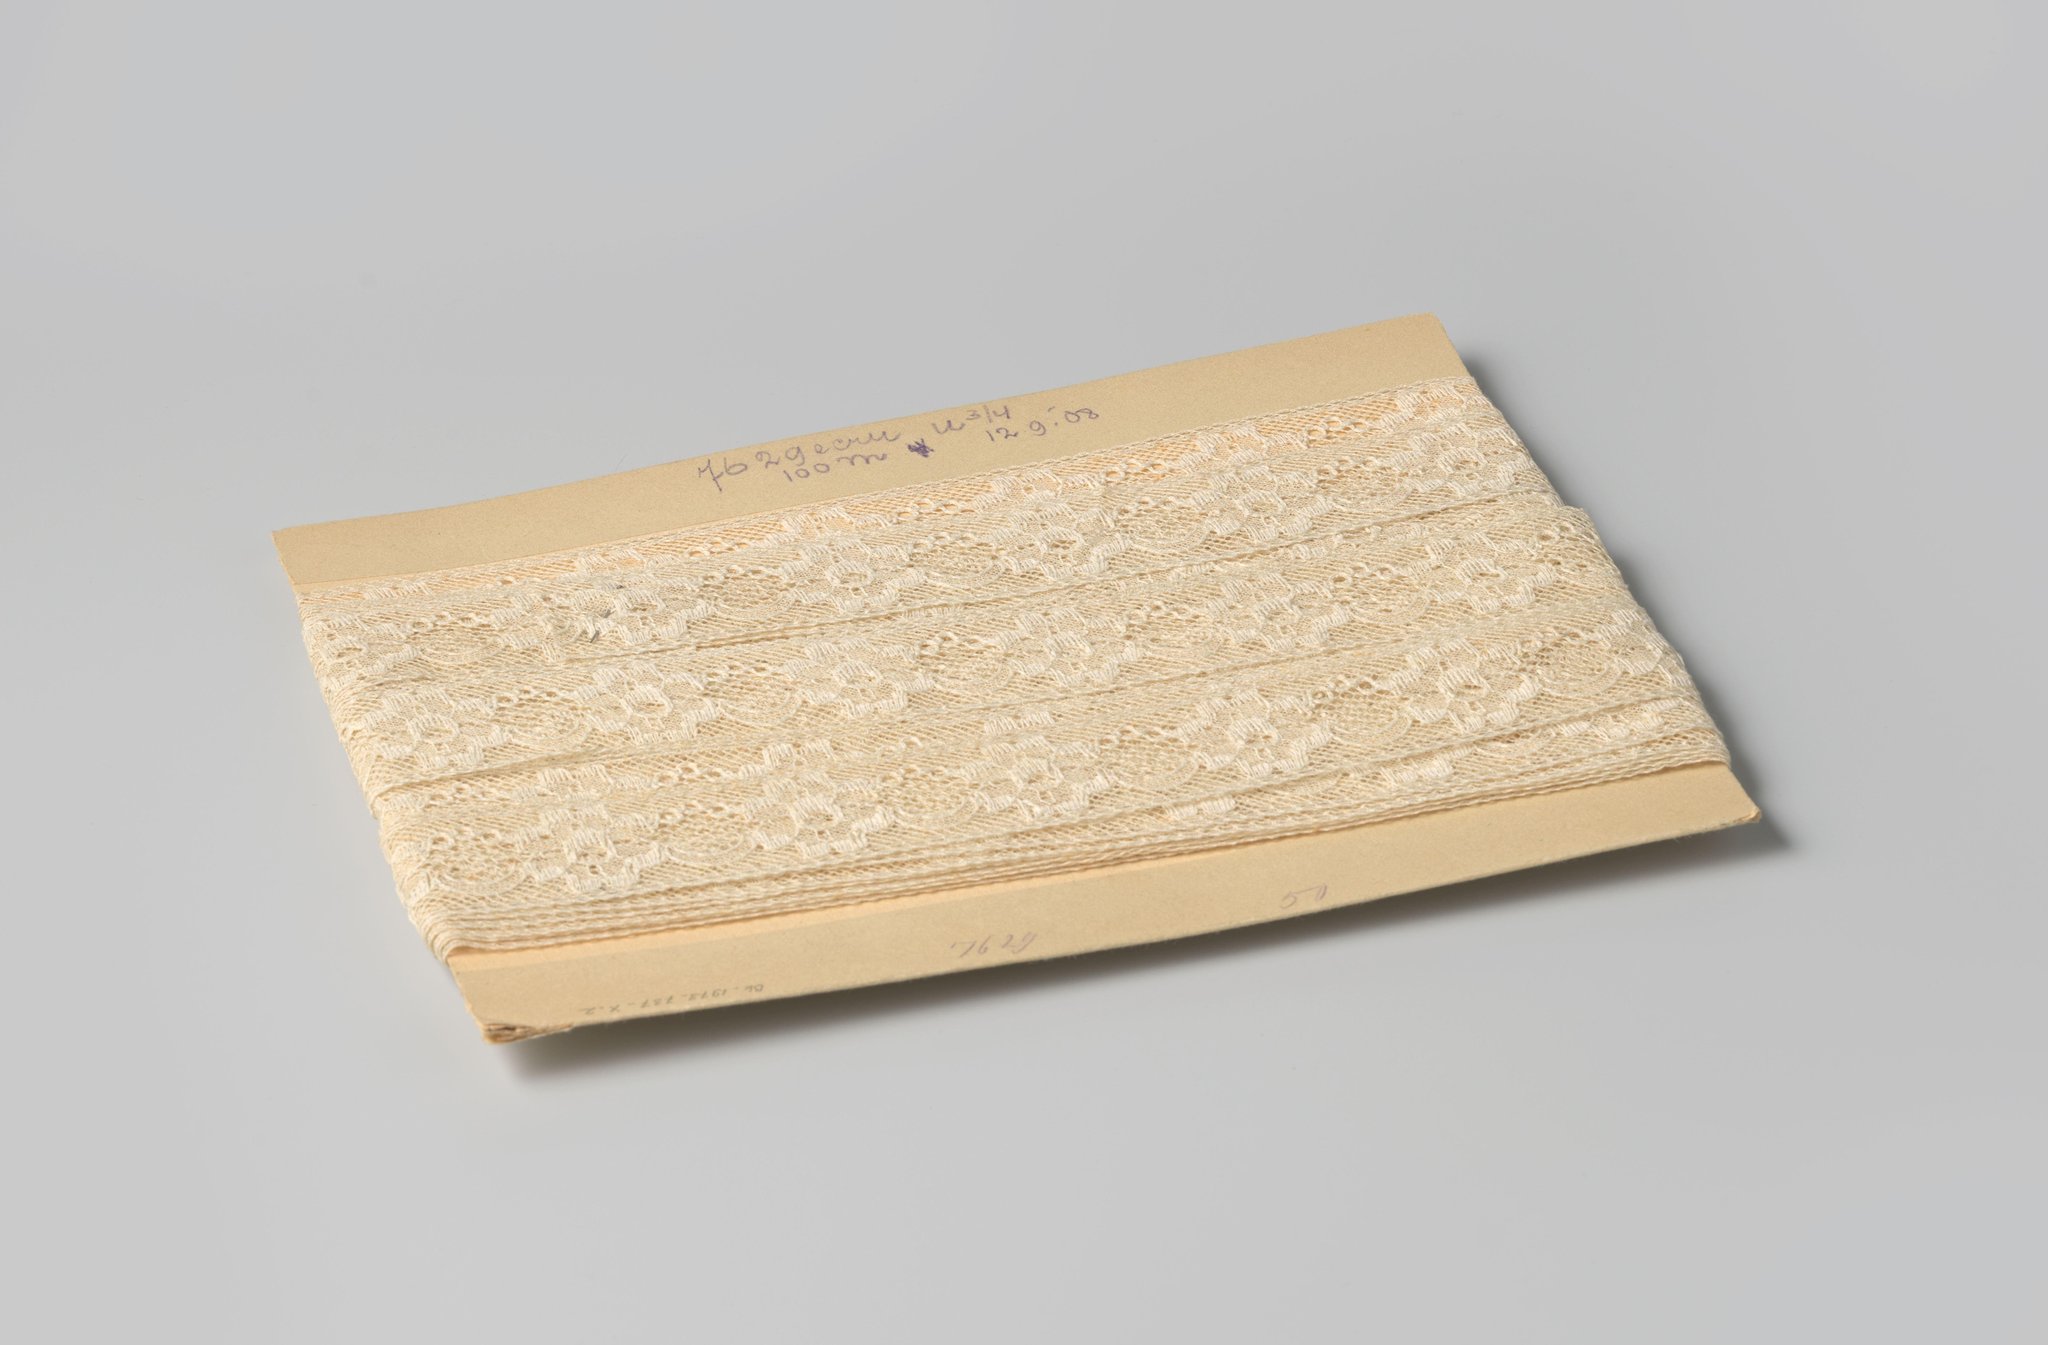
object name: entre deux, tussenzetsel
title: Tussenzetsel van roomwitte machinale kant met patroon van aaneengeschakelde bloemen, op karton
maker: gustav schnitzler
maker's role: paraplufabrikant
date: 1925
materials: cardboard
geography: nijmegen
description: Tussenzetsel van roomwitte machinale kant met patroon van aaneengeschakelde bloemen, op karton.